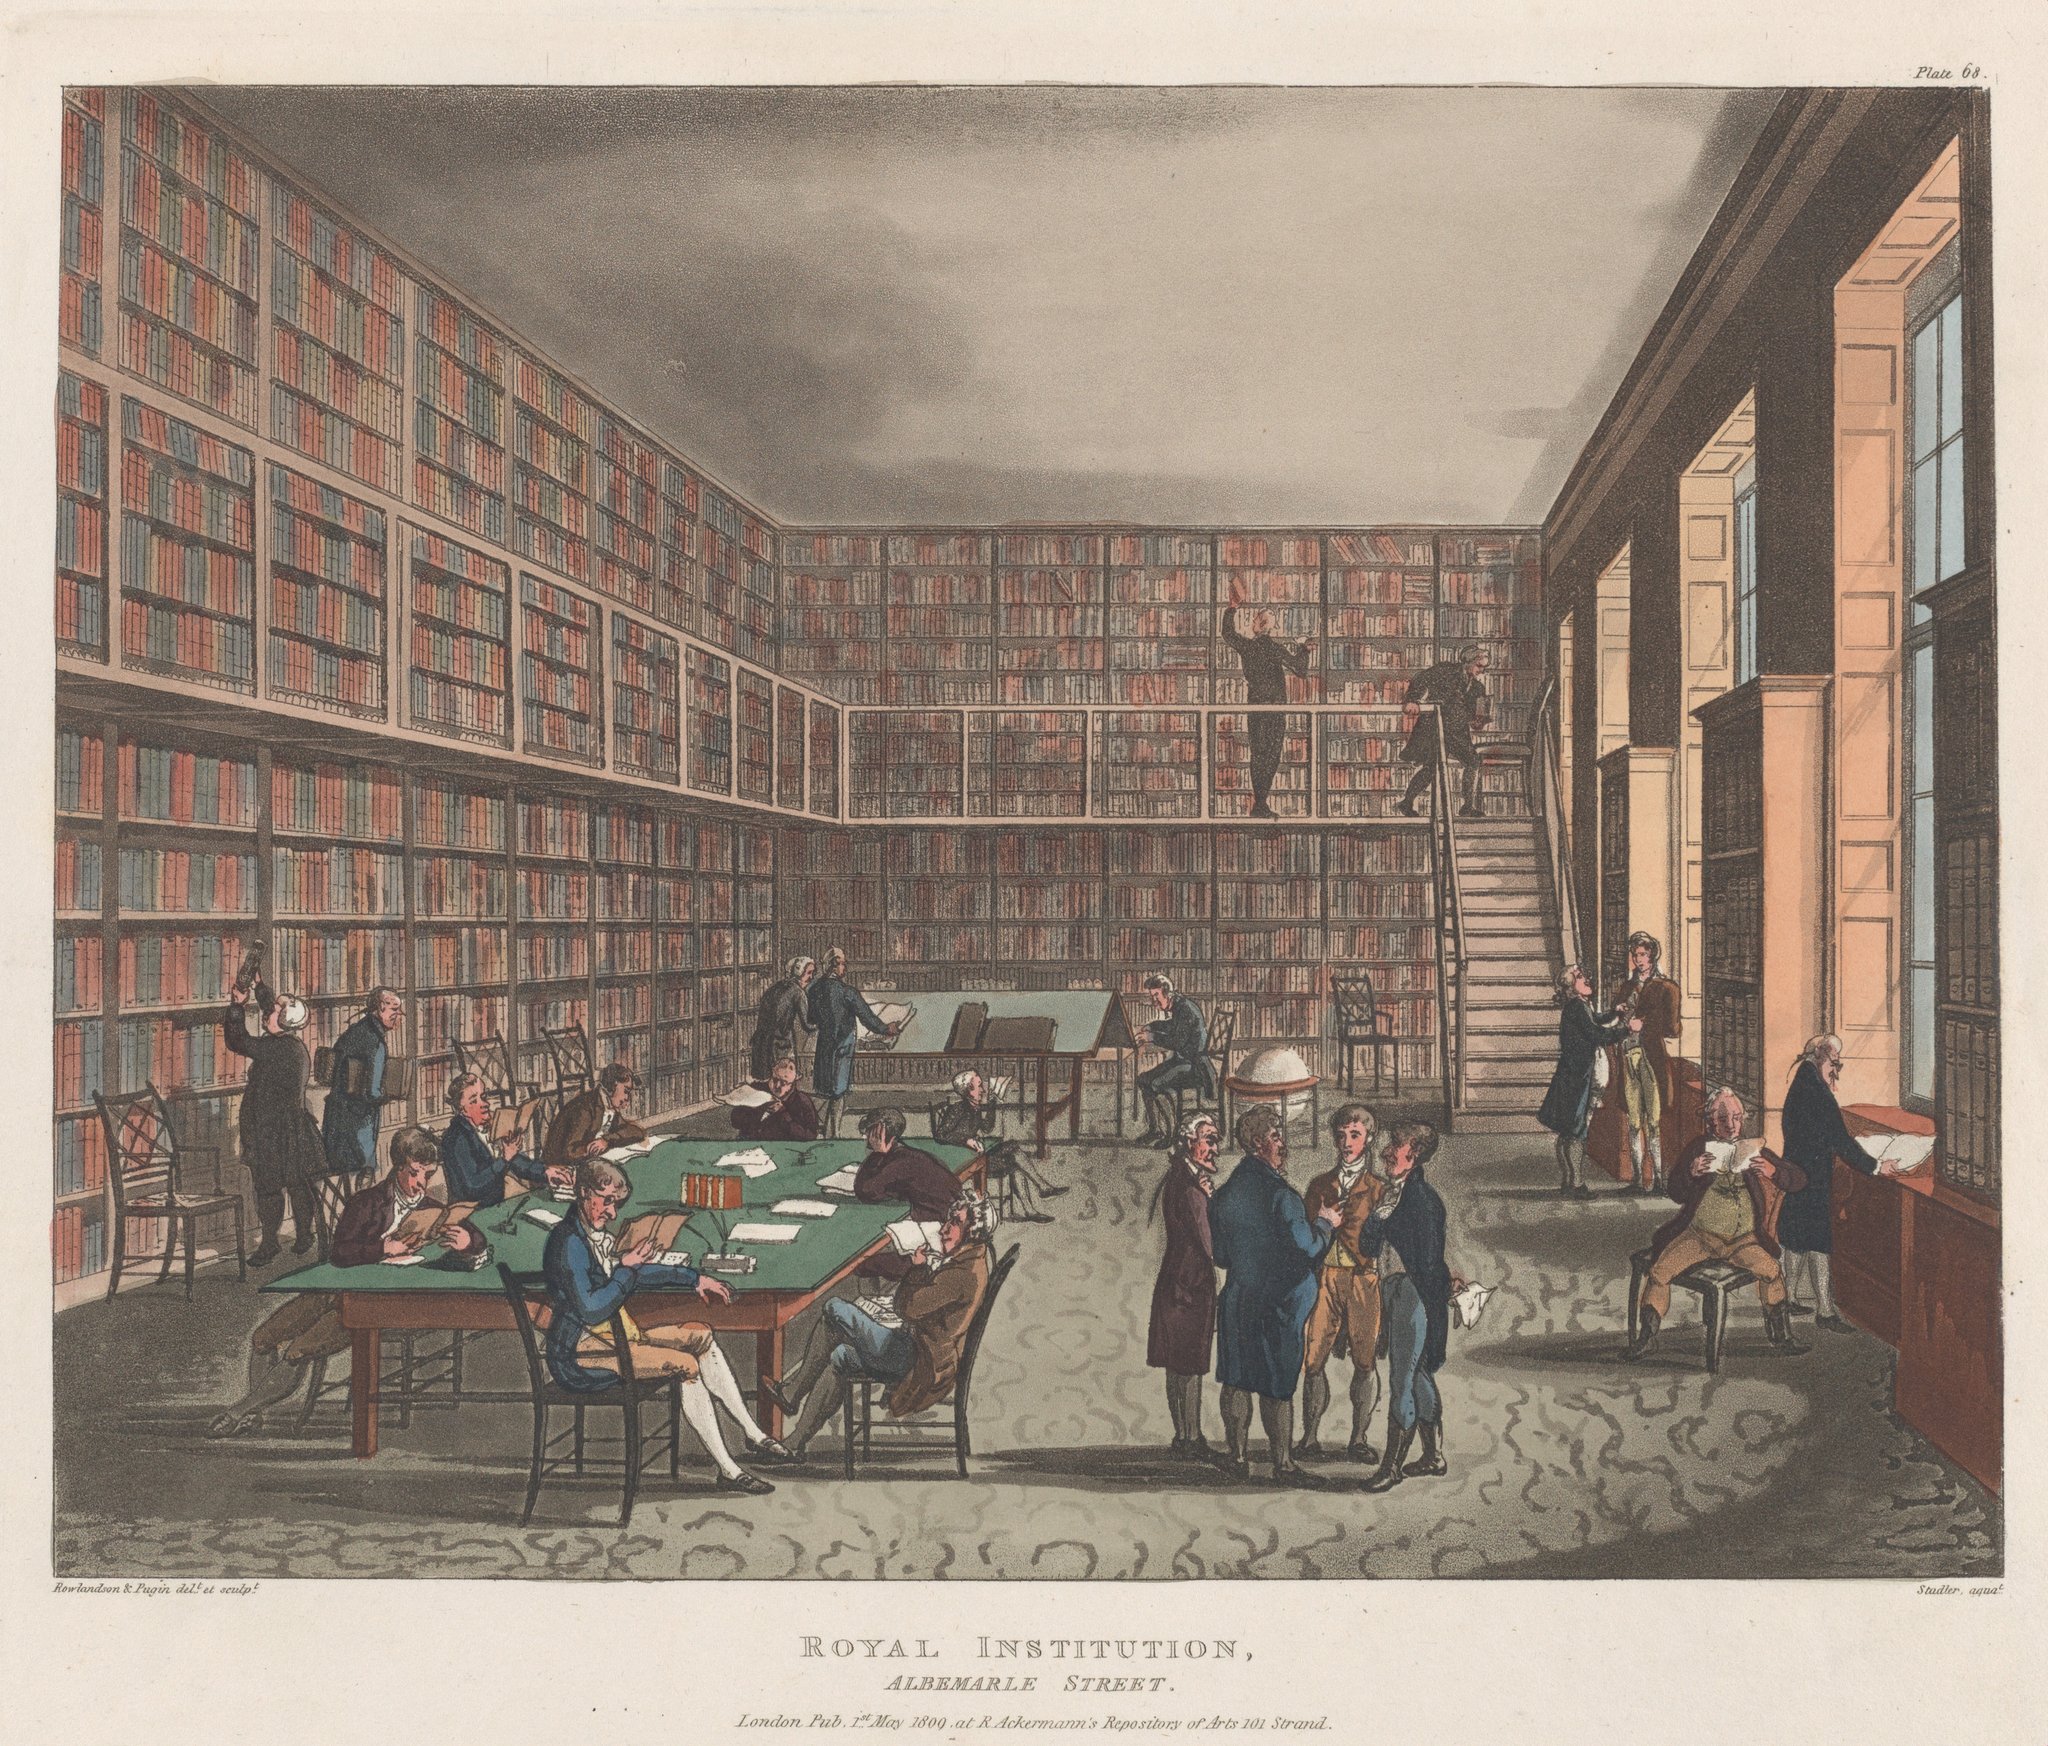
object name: print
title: Royal Institution, Albemarle Street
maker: thomas rowlandson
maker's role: artist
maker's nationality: british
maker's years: 1757-1827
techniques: aquatint, etching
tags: libraries,interiors,men,reading